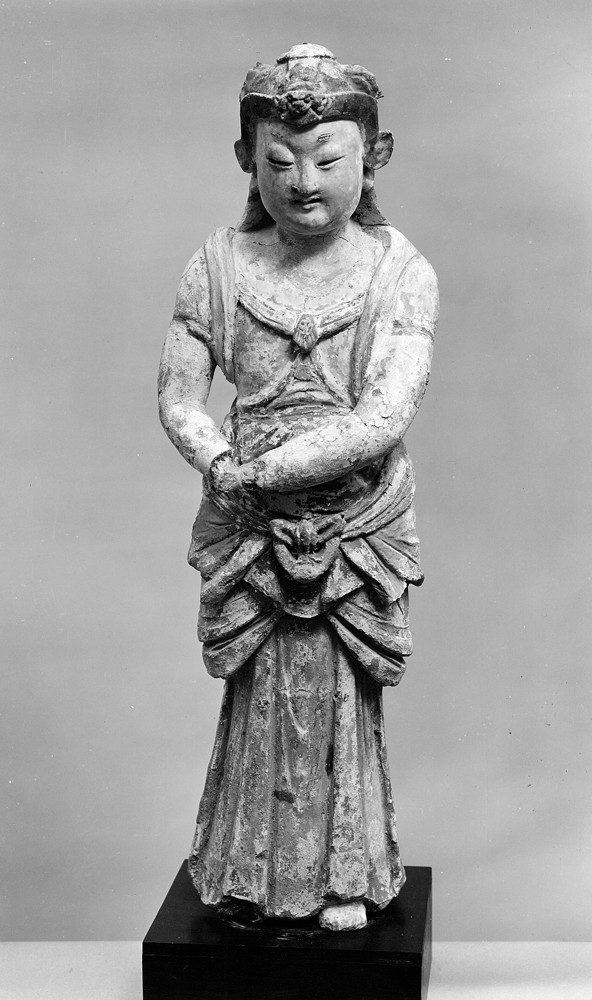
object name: figure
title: Bodhisattva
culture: chinese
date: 901-1000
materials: clay, pigment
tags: women